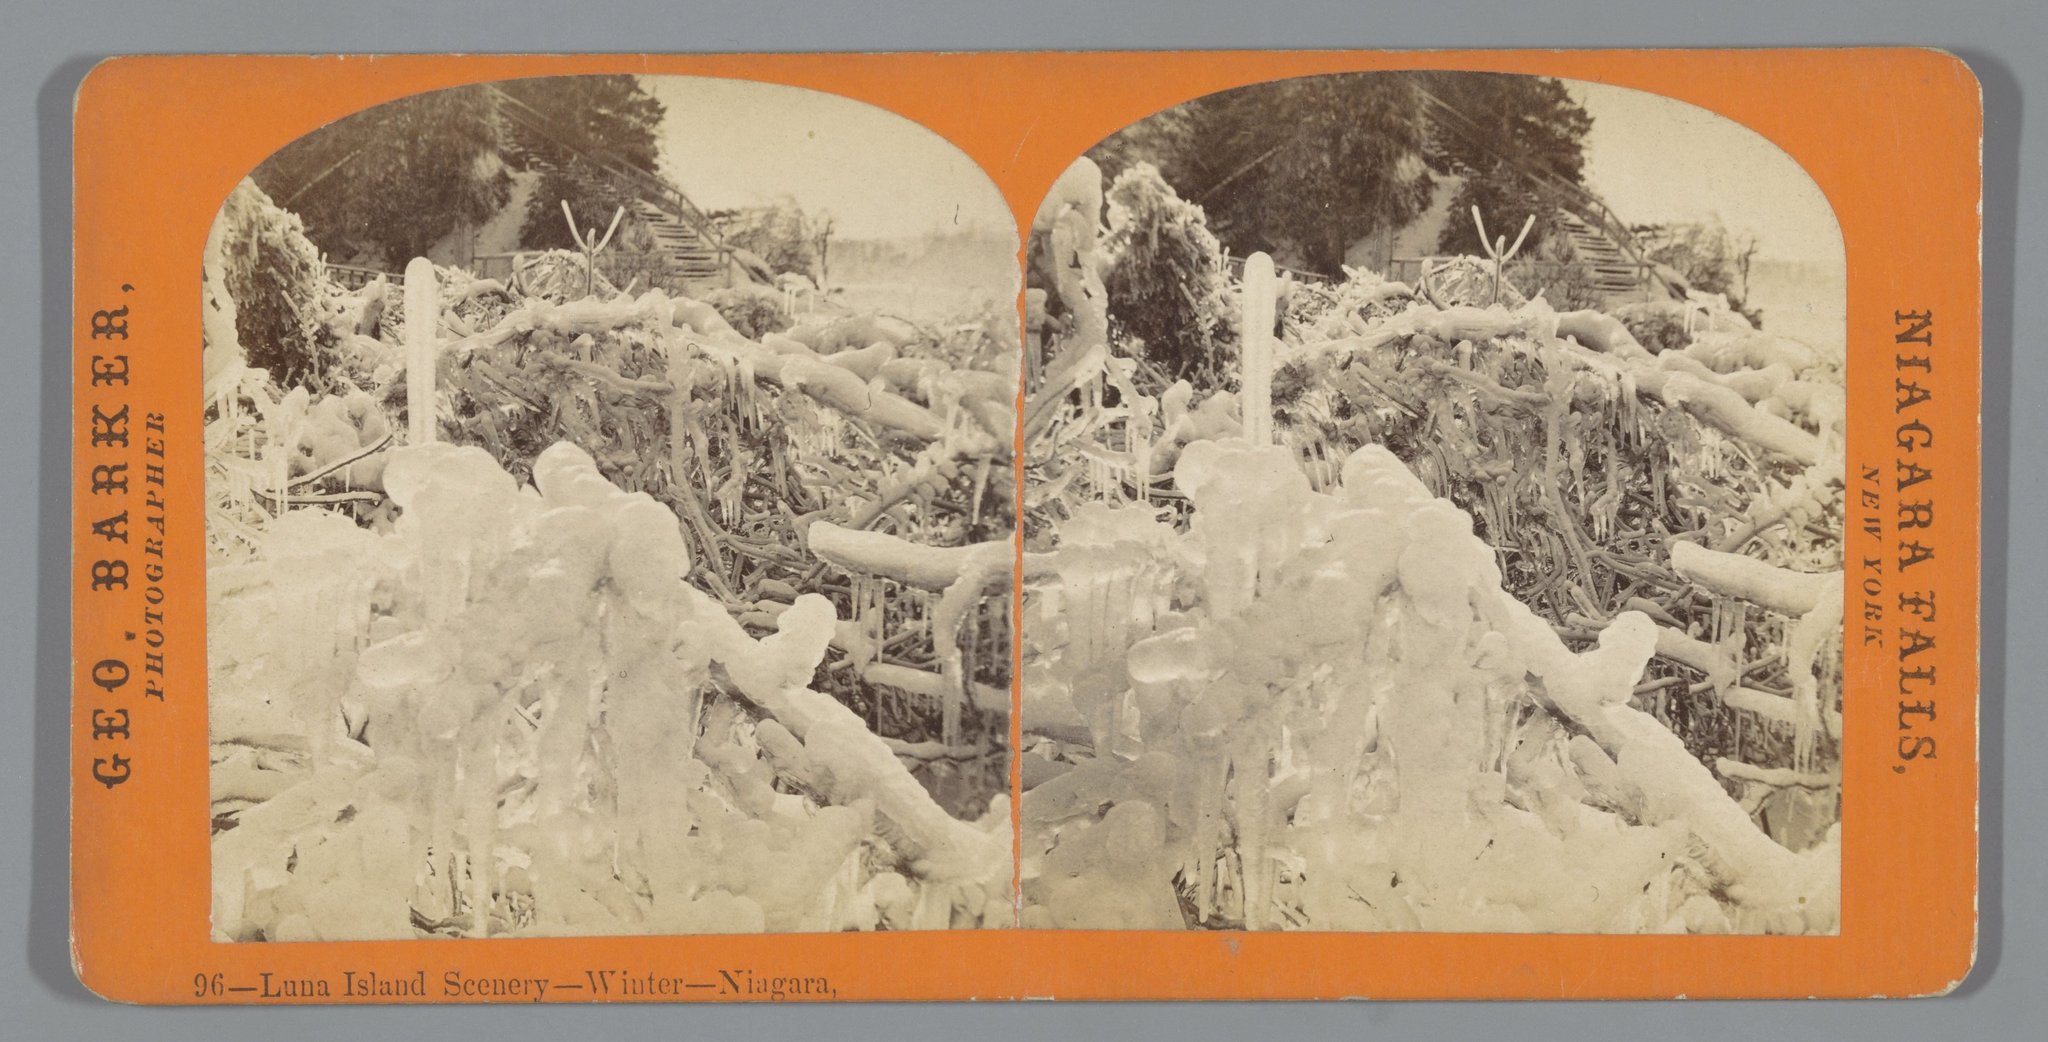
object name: stereograph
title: Niagara Falls, New York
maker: george barker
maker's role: fotograaf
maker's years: 1844-1894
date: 1863-1894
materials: cardboard, paper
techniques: albumen print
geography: luna island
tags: icicle, ice ~ state of water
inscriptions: number: ‘96’